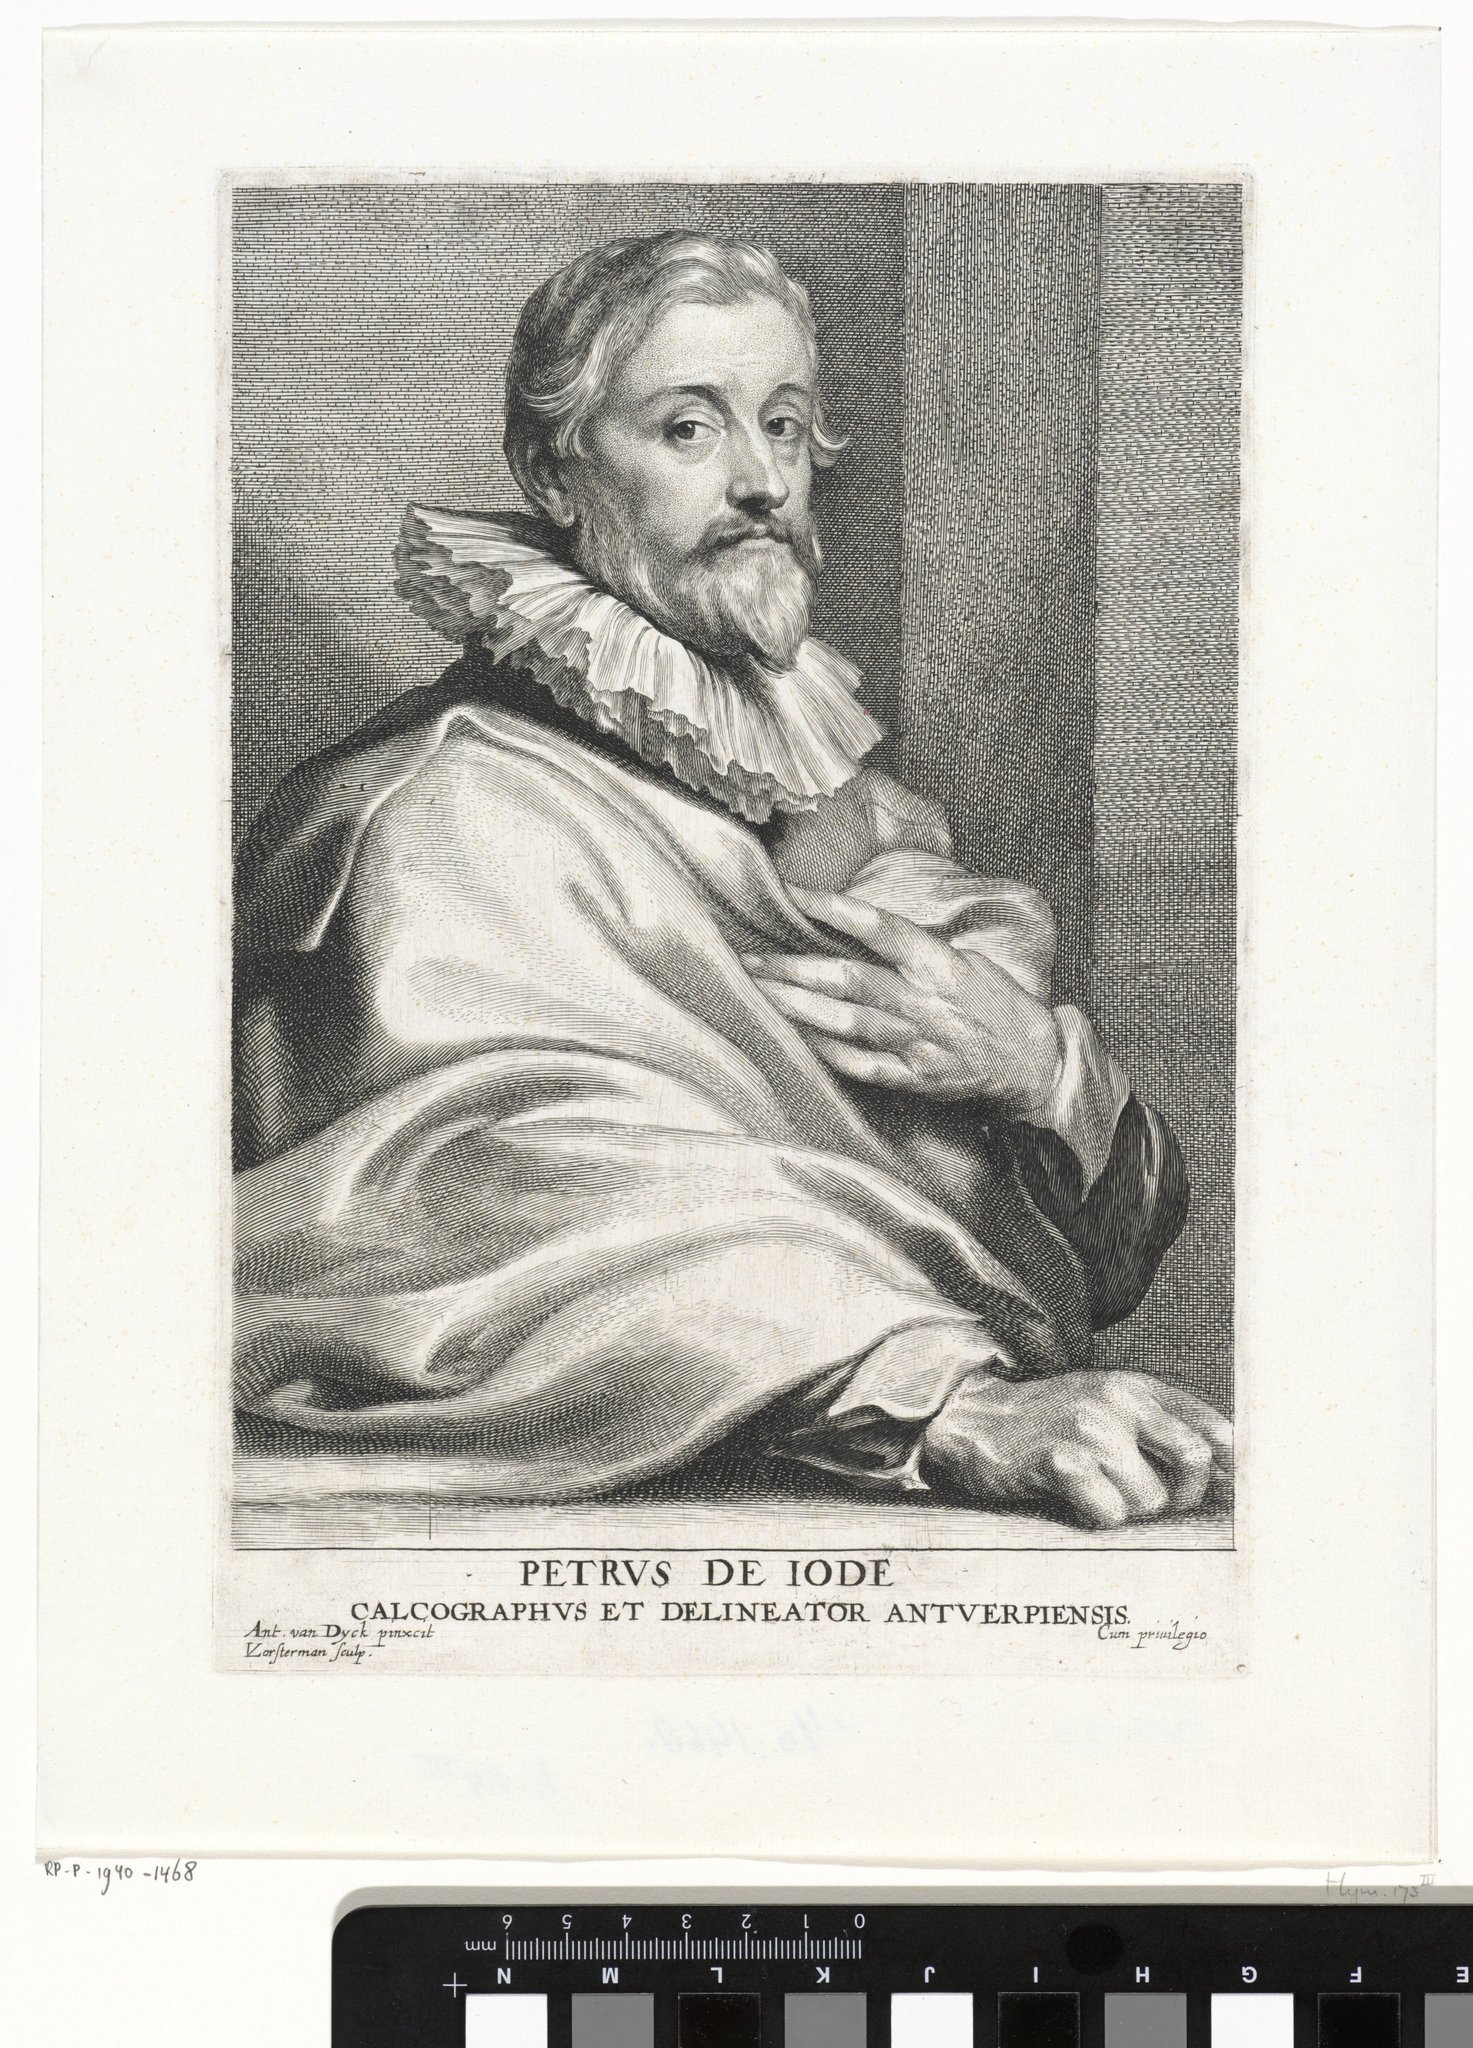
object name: print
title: Portret van Pieter de Jode (I)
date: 1630-1646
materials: paper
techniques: engraving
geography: antwerp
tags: pieter de jode (i)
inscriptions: collector's mark: Lugt 2760, collector's mark: Lugt 2228, collector's mark: Lugt 2166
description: Prent gebruikt voor: Icones principum, virorum doctorum, pictorum, chalcographorum, statuariorum nec non amatorum pictoriae artis numero centum ab Ant. van Dyck ad vivum expressae ejusque sumptibus aeri incisae. Antwerpen: Gillis Hendricx, [1645-1646].